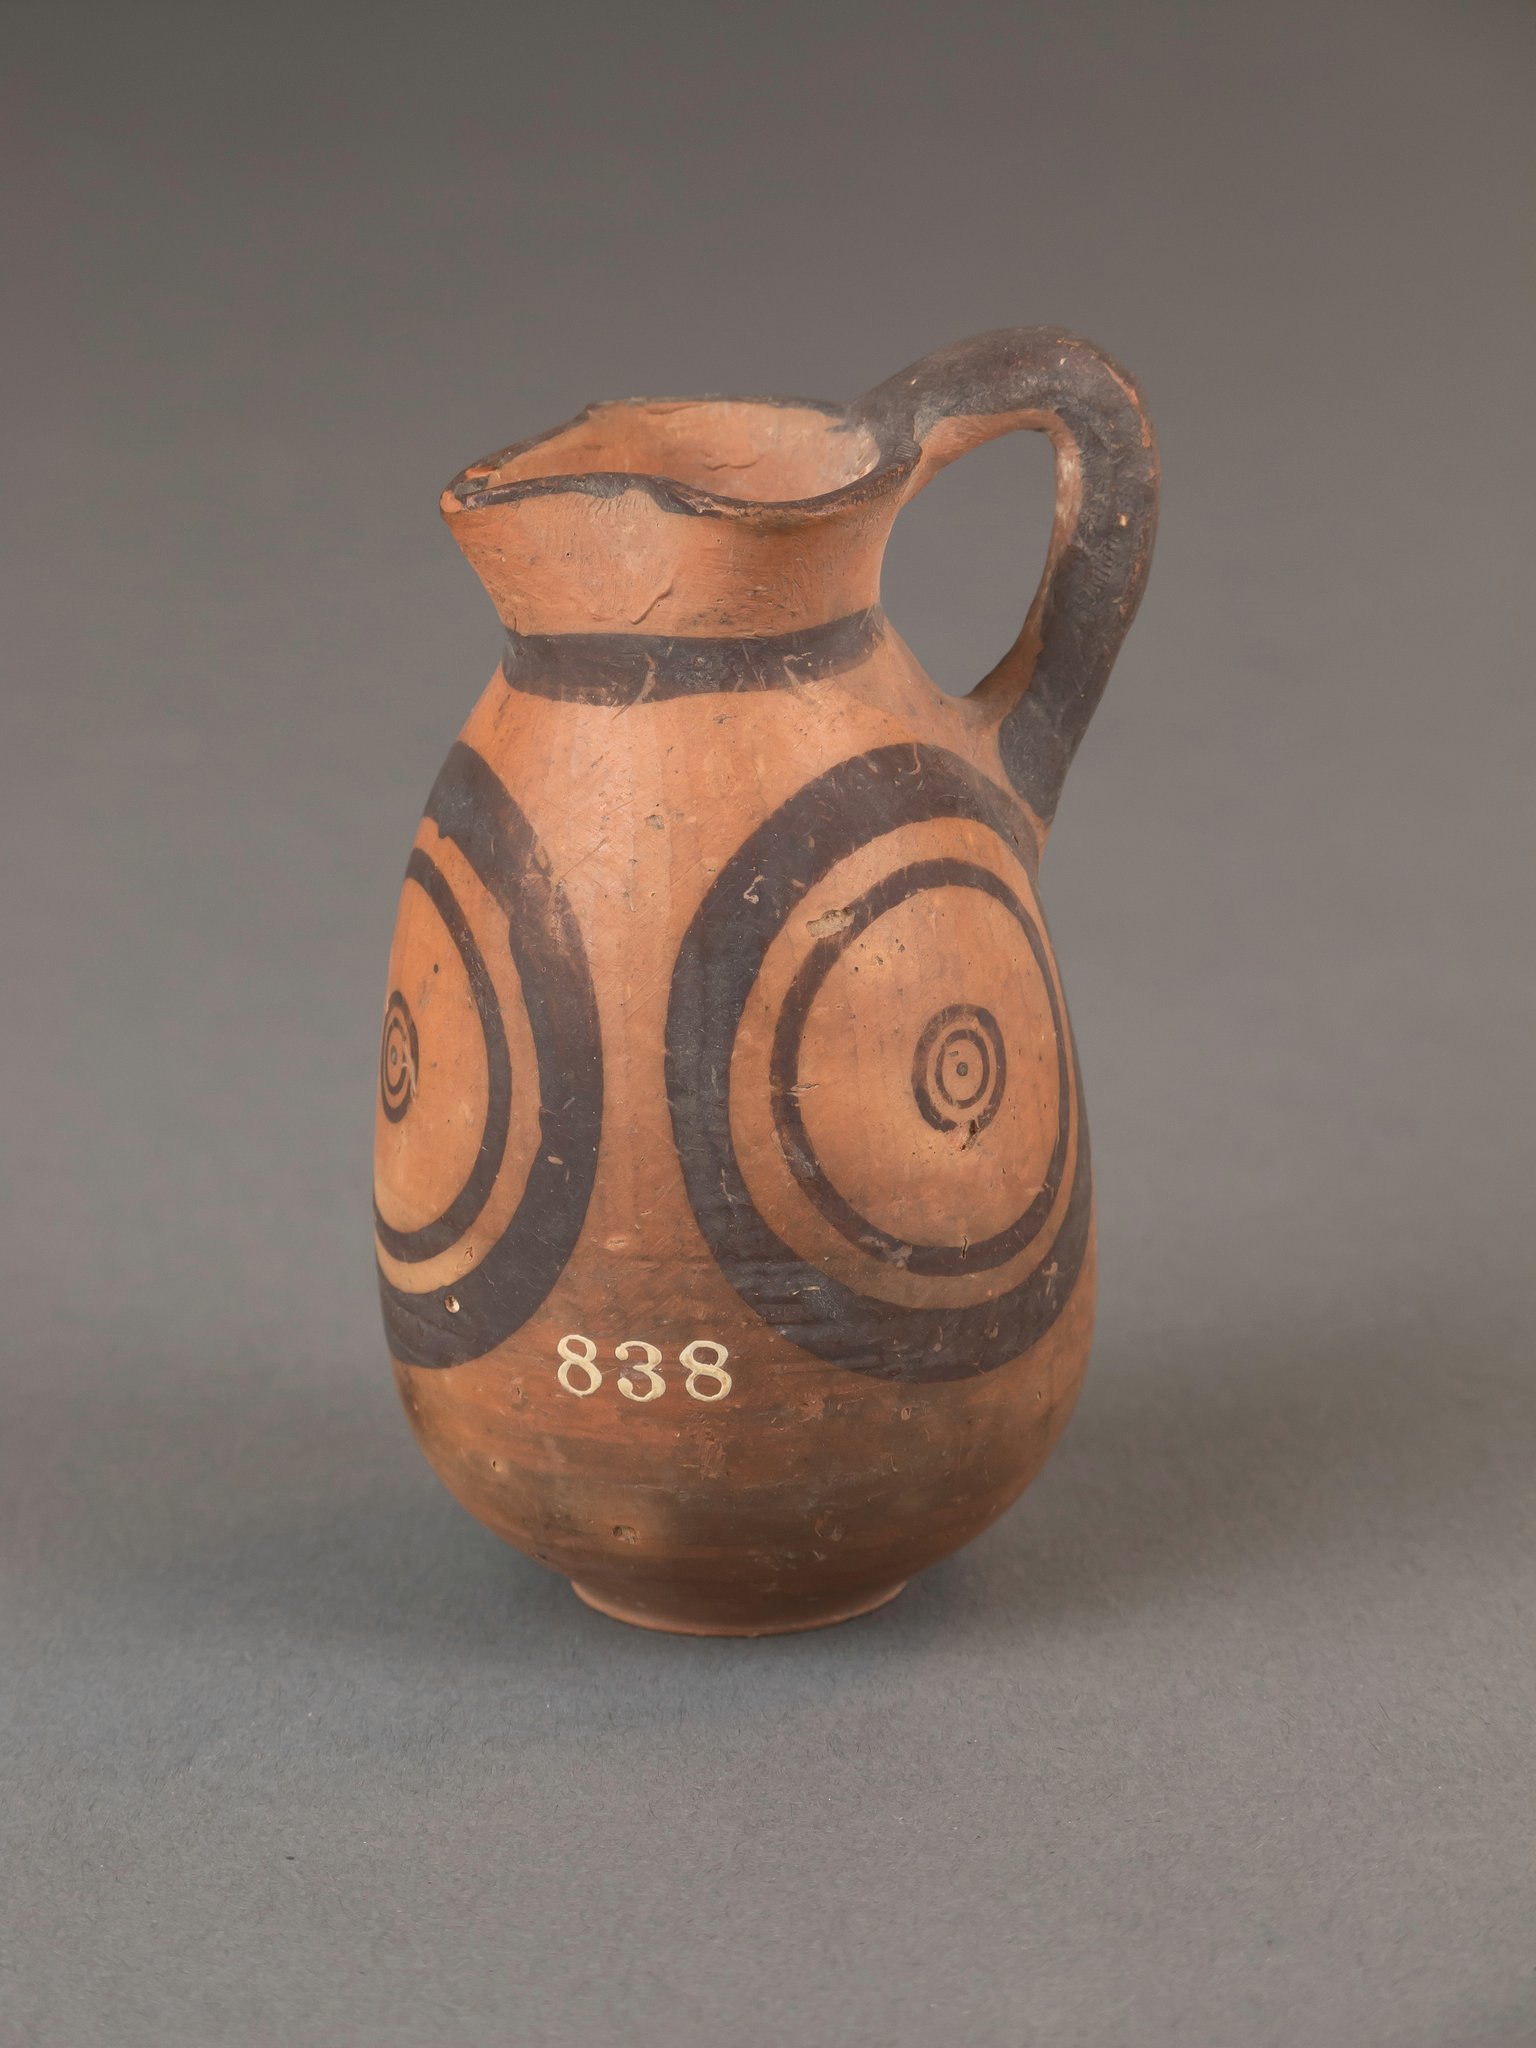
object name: juglet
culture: cypriot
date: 750-600 BCE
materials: terracotta